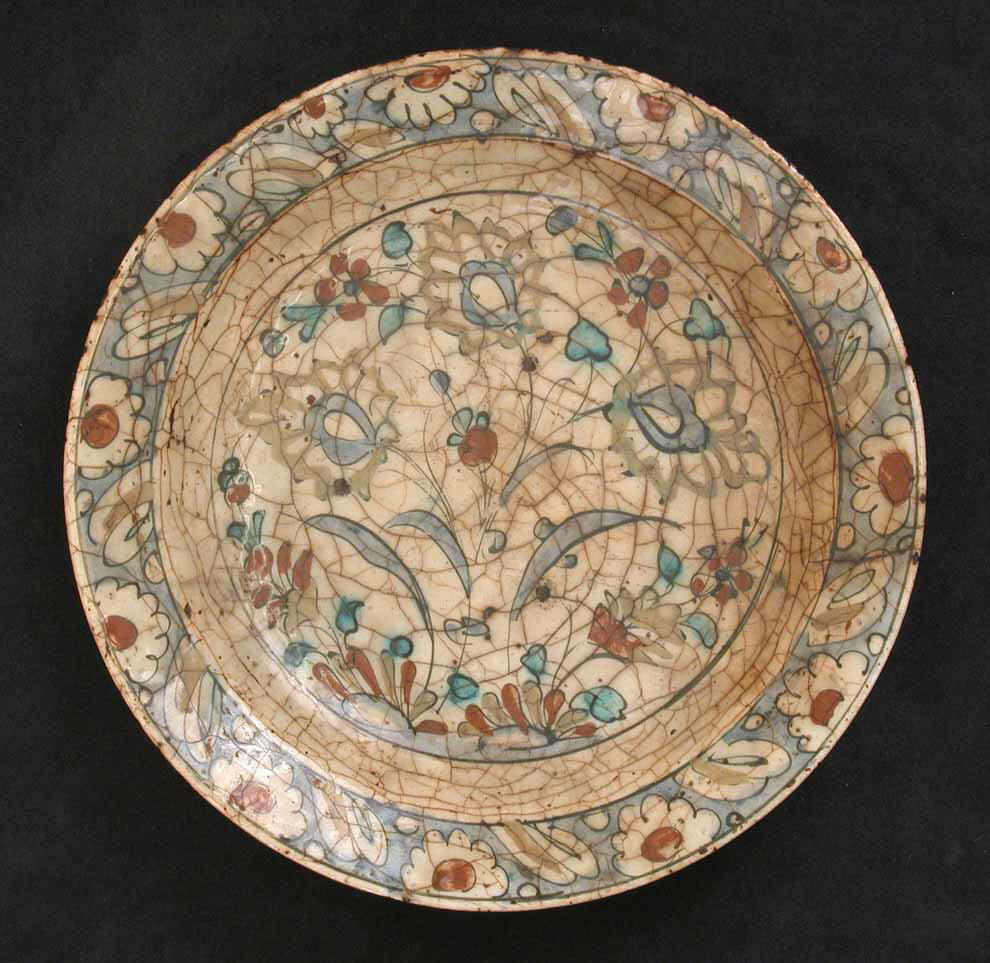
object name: dish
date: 1601-1700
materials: stonepaste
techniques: painting, underglaze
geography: iran